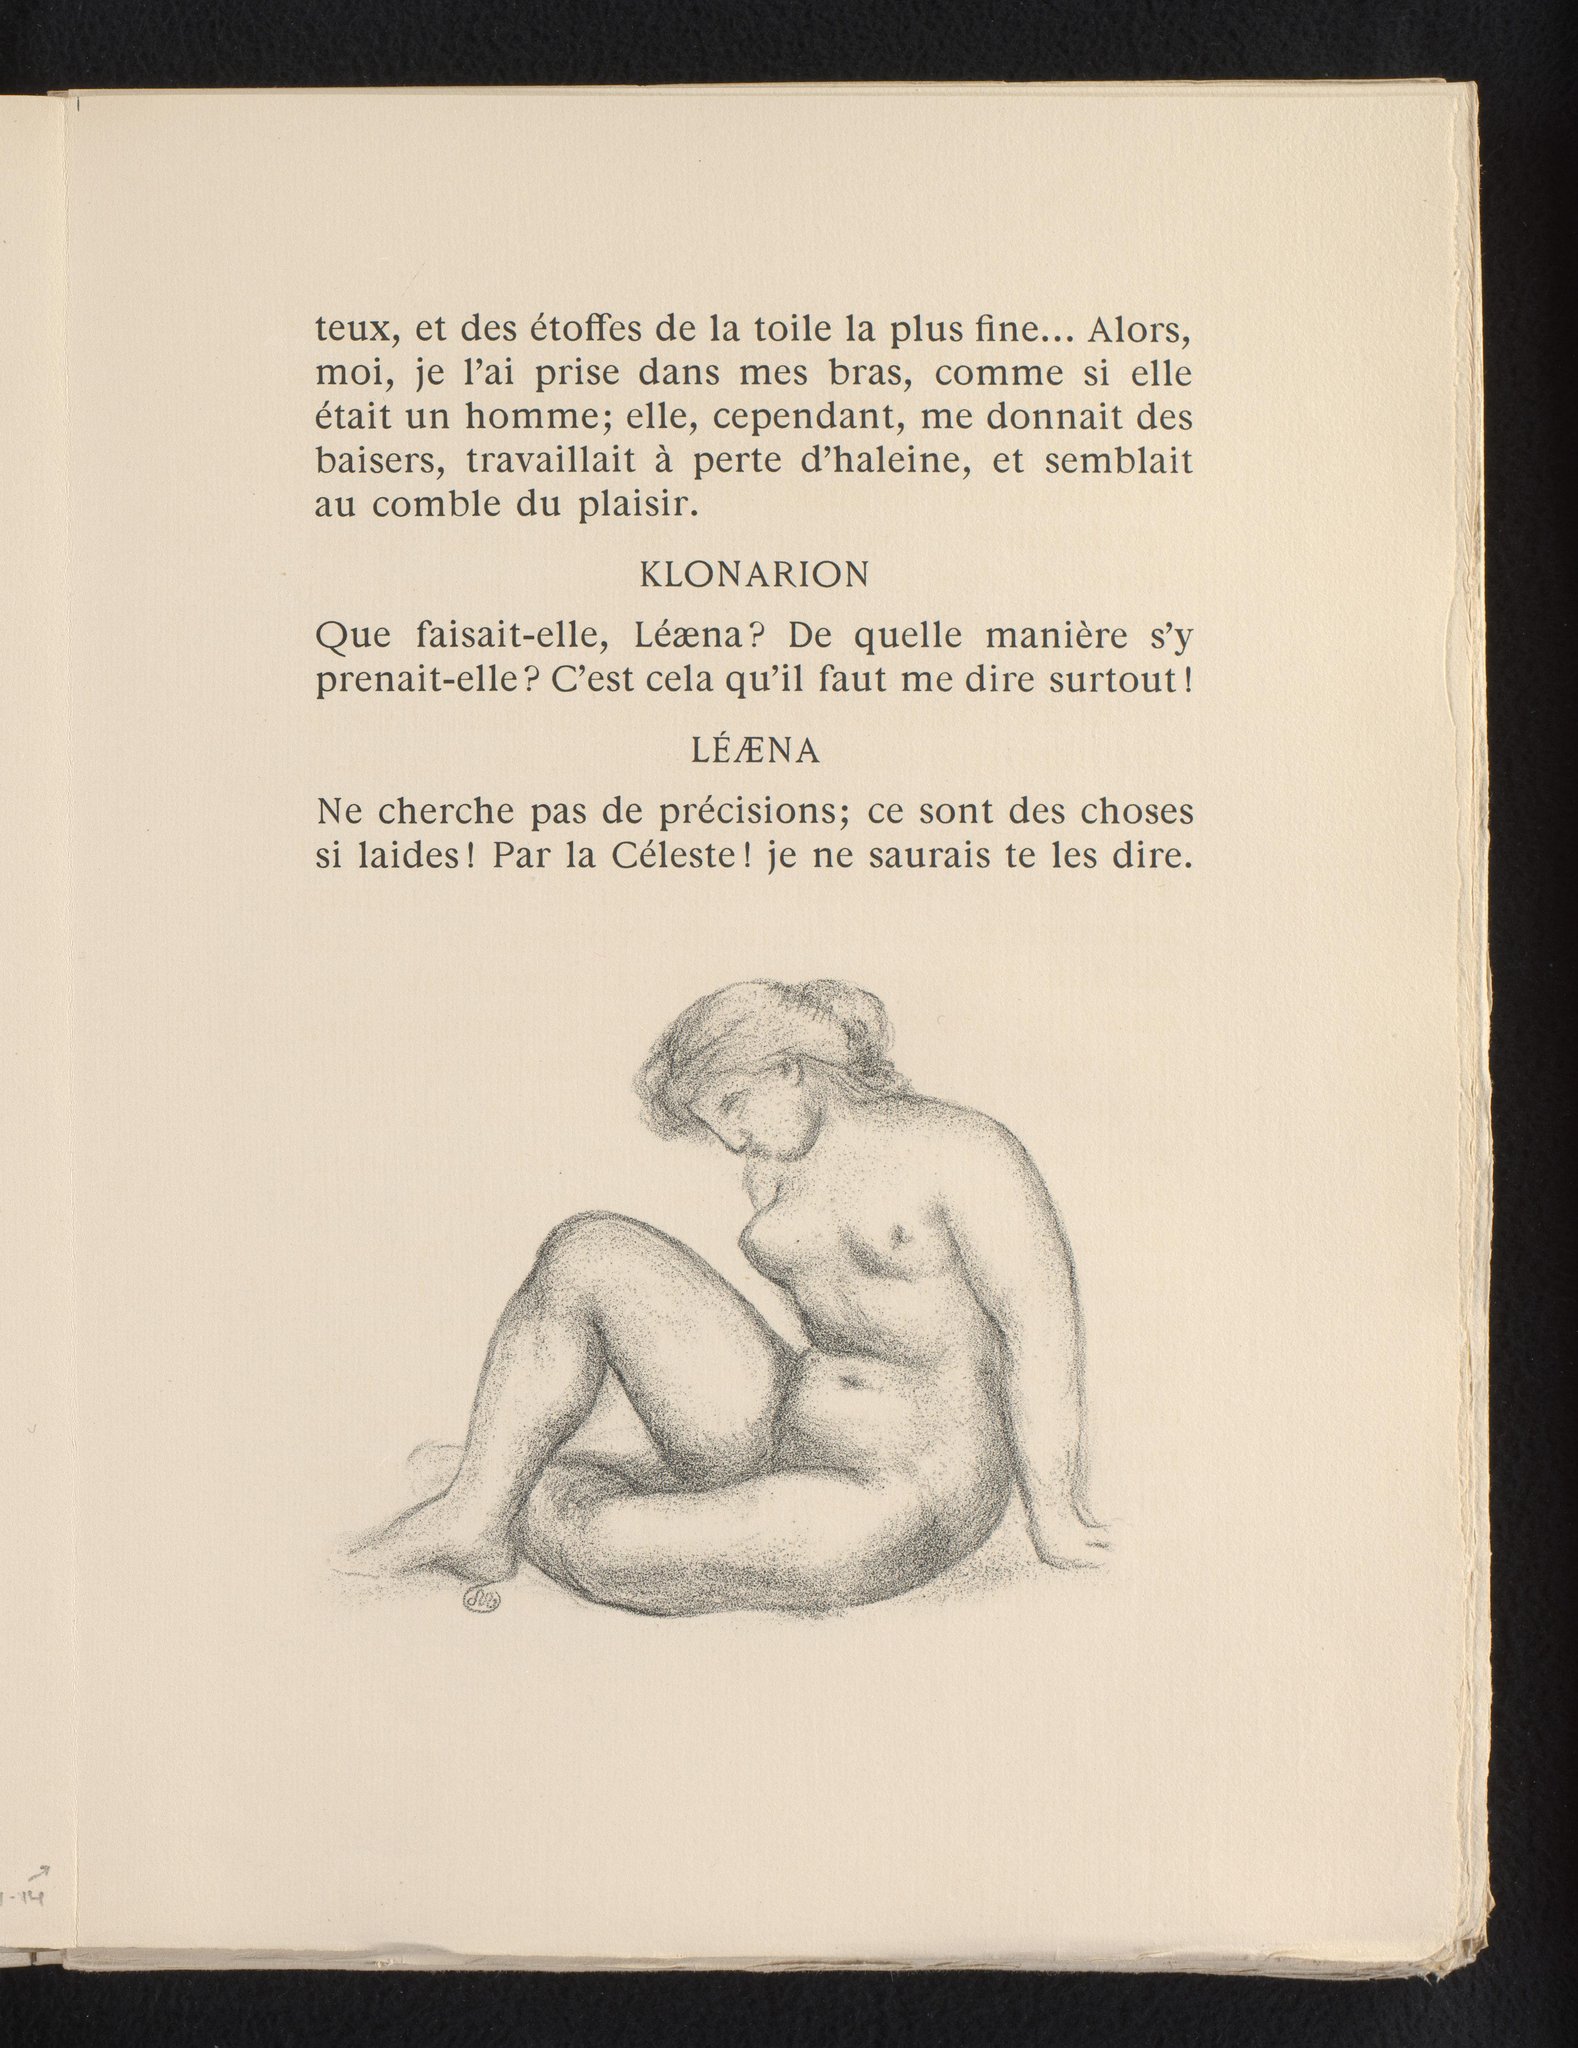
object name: print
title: Op de grond zittende naakte vrouw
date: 1948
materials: paper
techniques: letterpress printing, lithograph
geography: paris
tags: sitting figure - aa - female human figure, woman (showing herself) undressed, quasi-nude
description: Prent uit: Lucianus van Samosata. Dialogues des Courtisanes. [Vertaald uit het Grieks door] Charles Astruc. Parijs: s.n., 1948, p. 29.